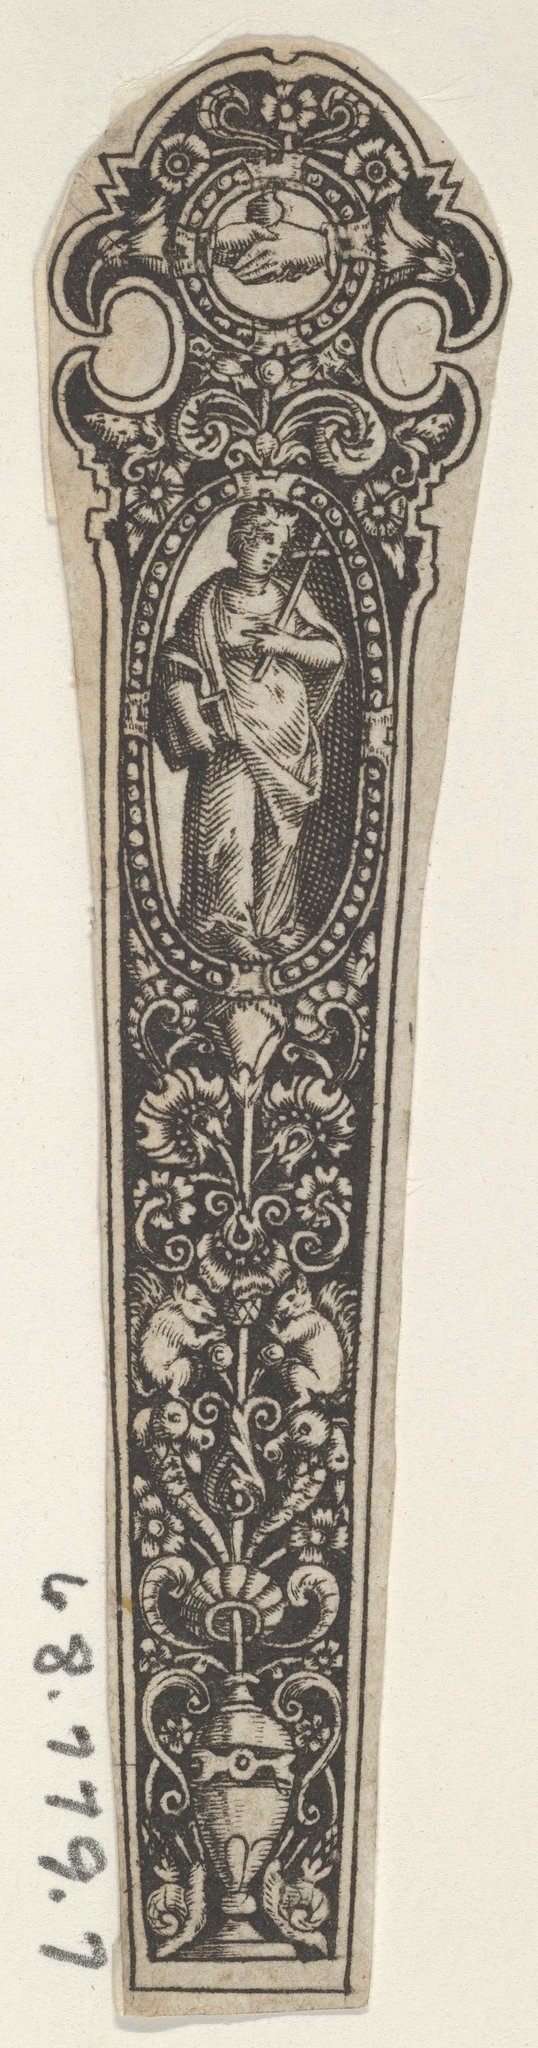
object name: print ornament architecture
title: Copy of a Design for a Knife Handle with the Personification of Faith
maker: johann theodor de bry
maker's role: artist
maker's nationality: netherlandish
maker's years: 1561-1623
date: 1580-1600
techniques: embroidery, engraving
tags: hands,women,squirrels,cross